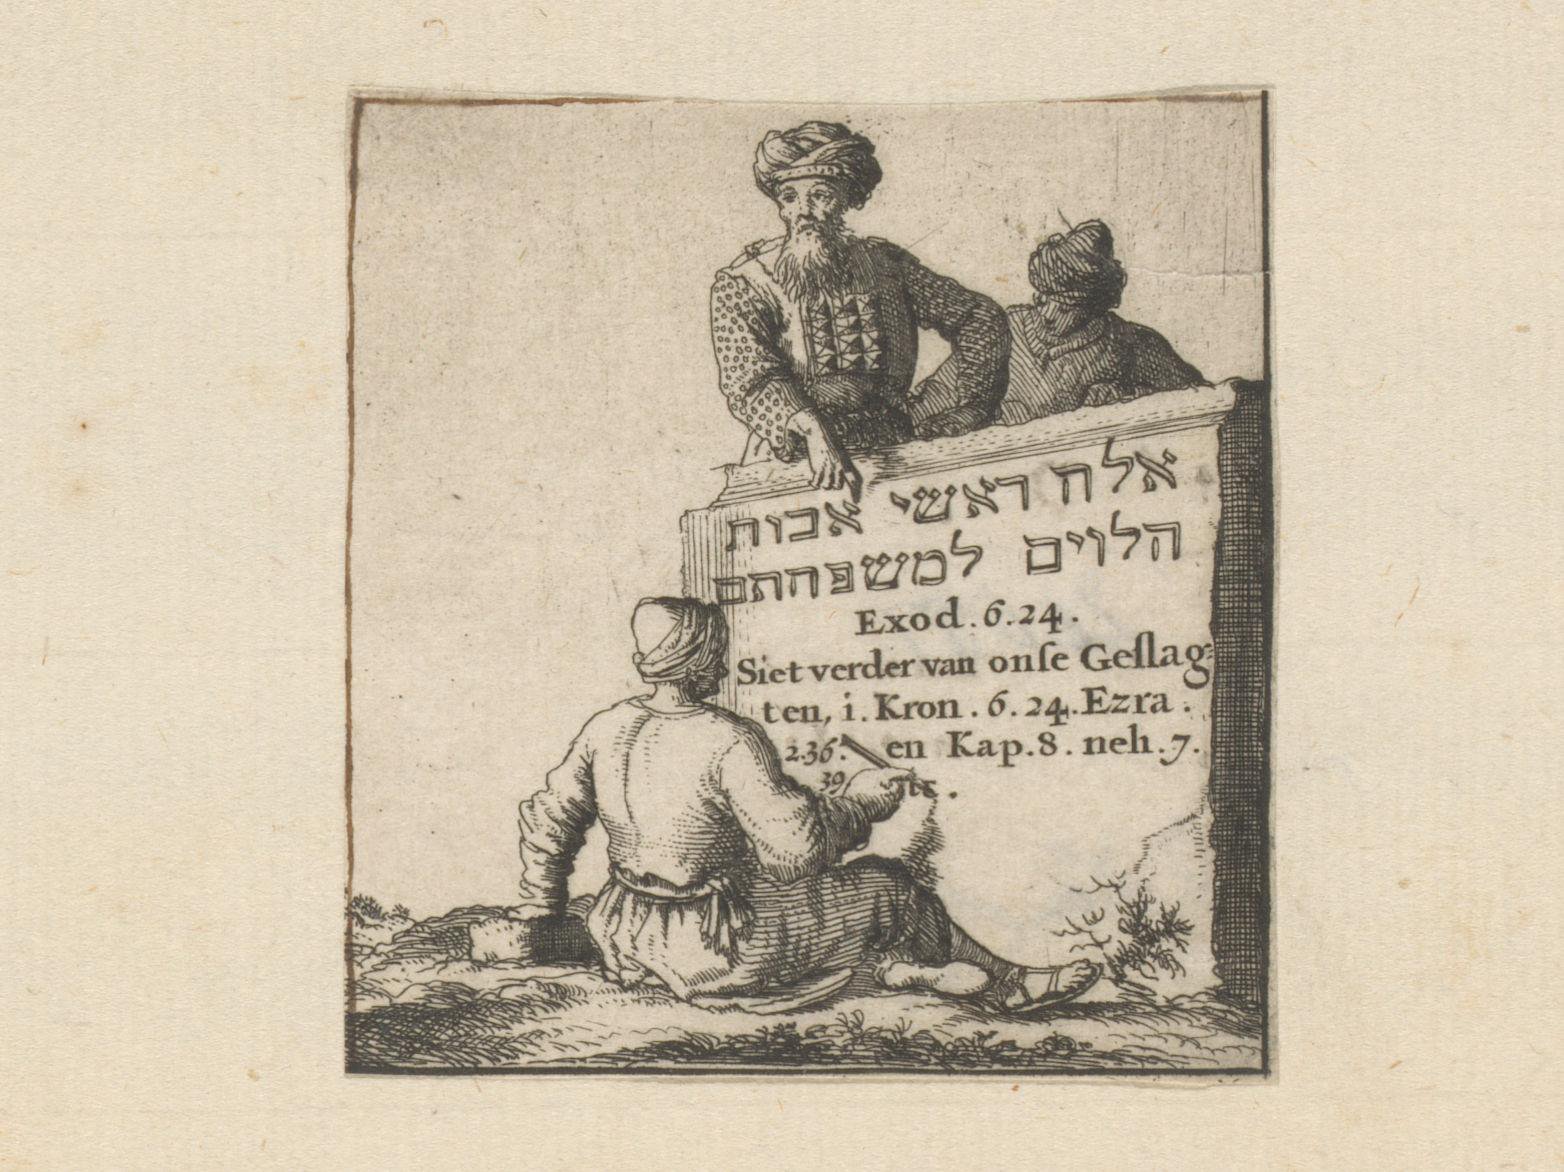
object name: print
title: Titelprent met 3 personen en Hebr. opschrift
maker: jan luyken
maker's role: draughtsman, print maker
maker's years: 1649-1712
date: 1659-1712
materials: paper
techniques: etching